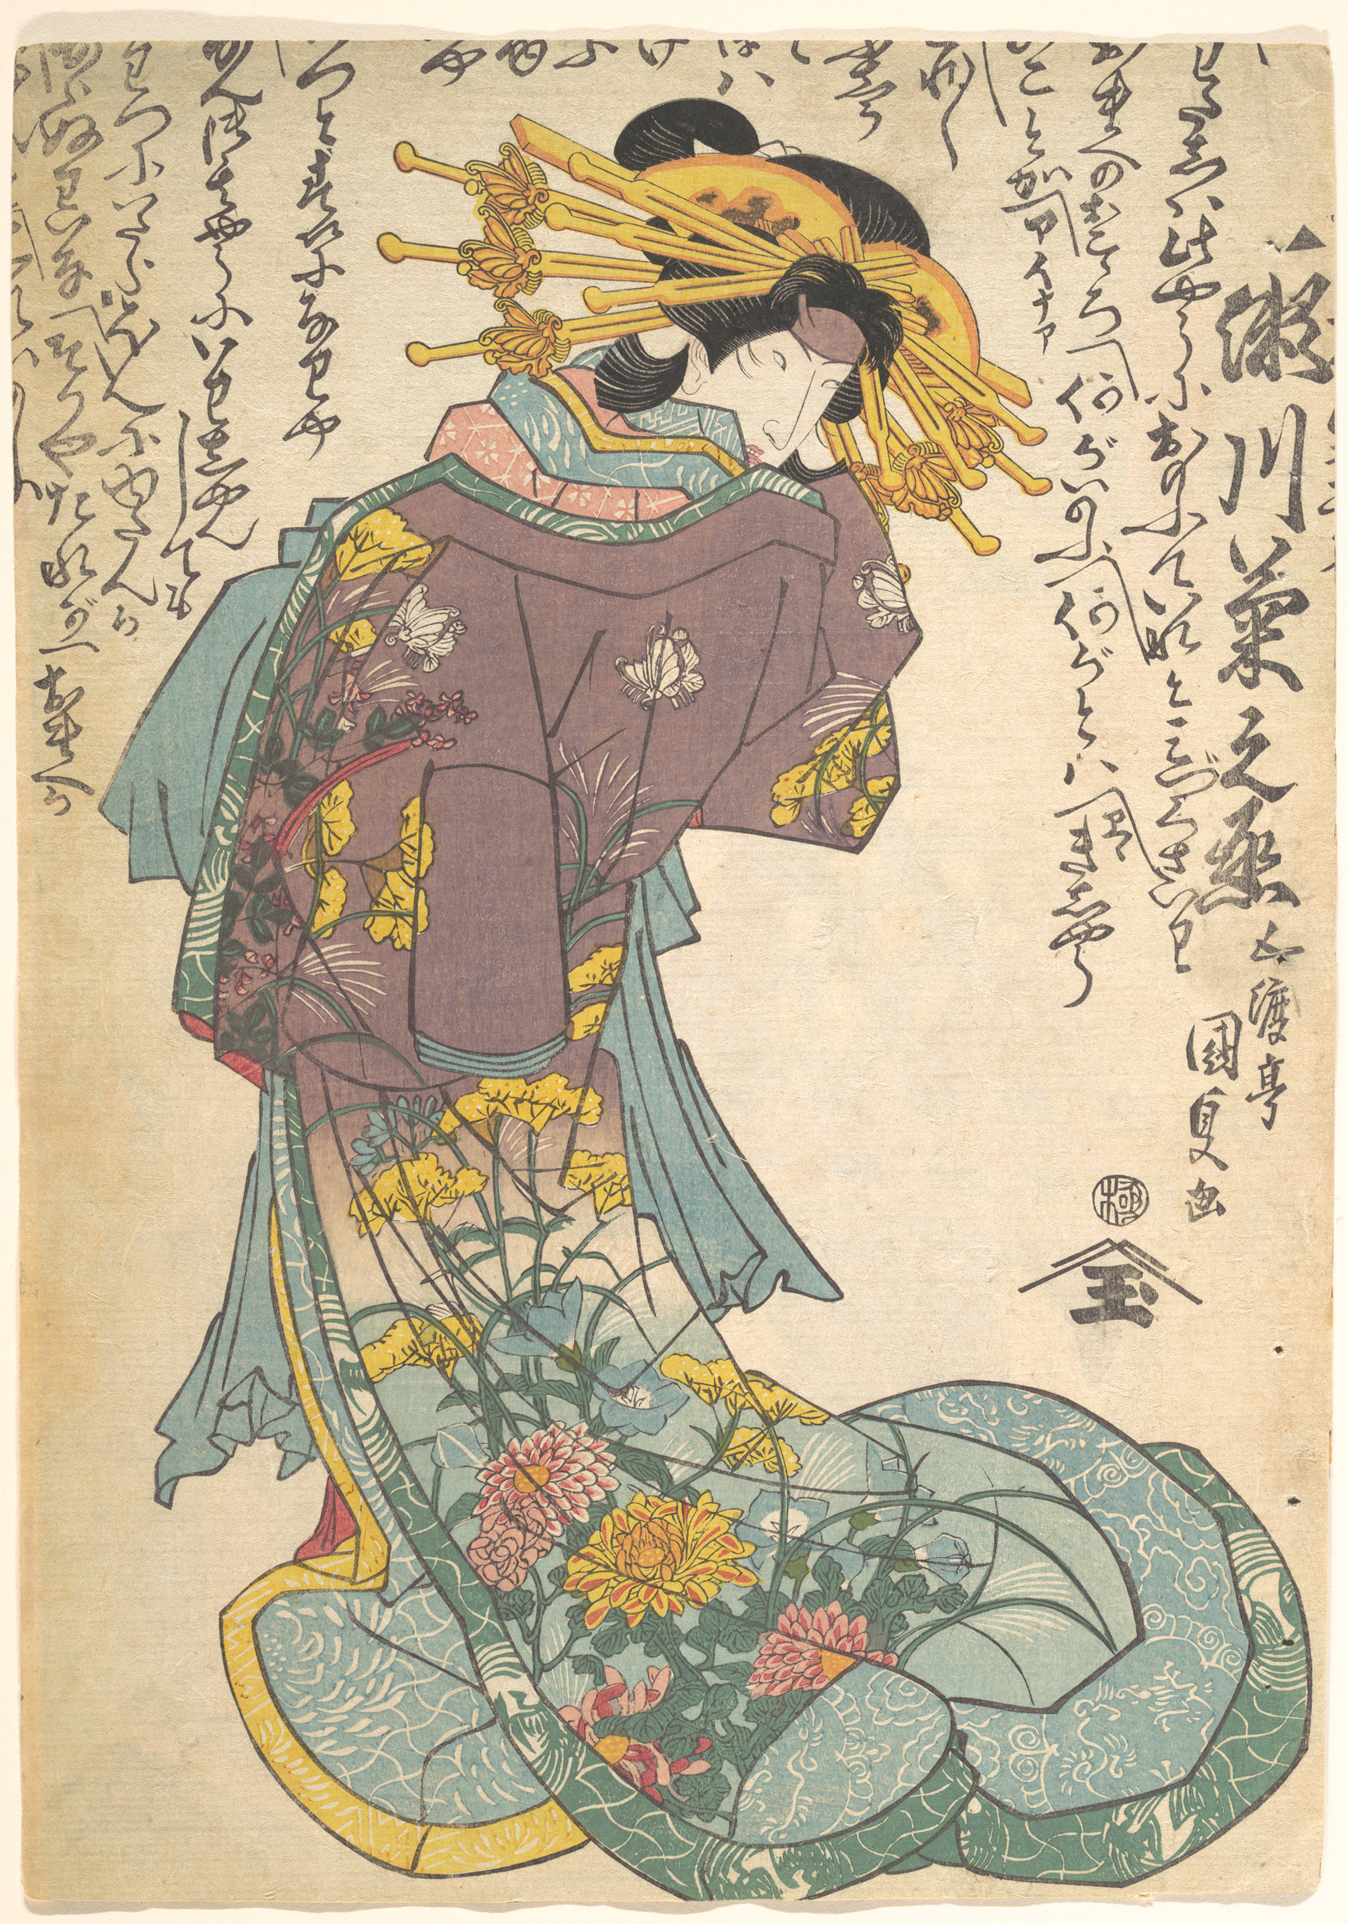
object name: print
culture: japanese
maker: utagawa kunisada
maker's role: artist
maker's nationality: japanese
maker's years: 1786-1864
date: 1801-1900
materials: ink, paper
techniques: woodblock print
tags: women,flowers,leaves